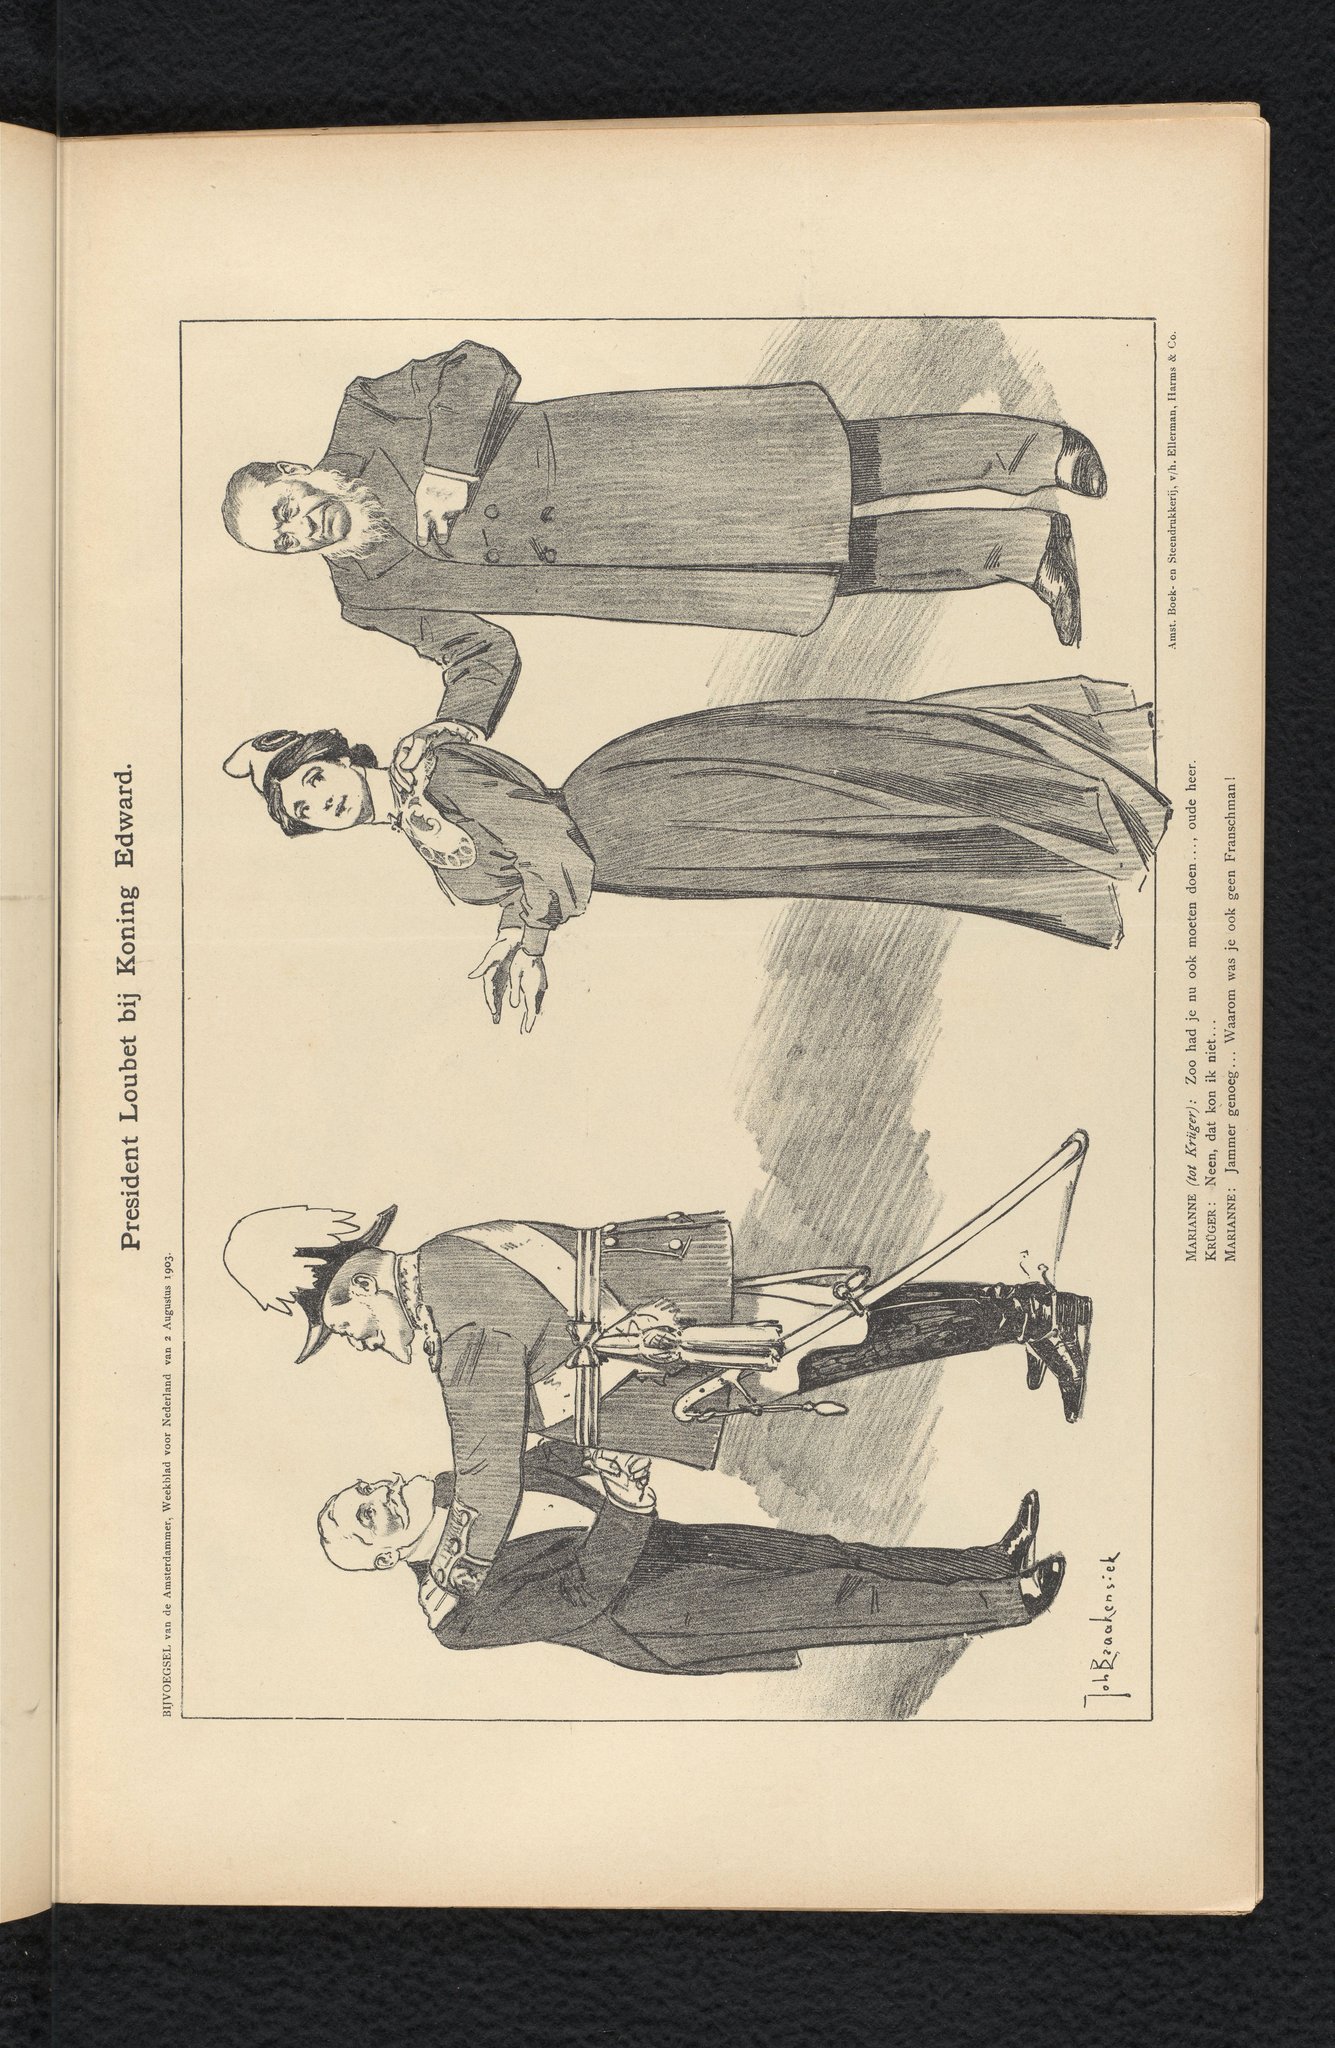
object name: cartoon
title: President Loubet bij Koning Edward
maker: johan braakensiek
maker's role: draughtsman, print maker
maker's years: 1858-1940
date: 1903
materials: paper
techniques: lithograph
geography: amsterdam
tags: shaking hands, 'dextrarum junctio', personifications of countries, nations, states, districts, etc., political caricatures and satires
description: De Franse president Loubet schudt hartelijk de hand van de Engelse koning Edward VII, rechts kijken Marianne (Frankrijk) en de Zuid-Afrikaanse president Kruger toe.